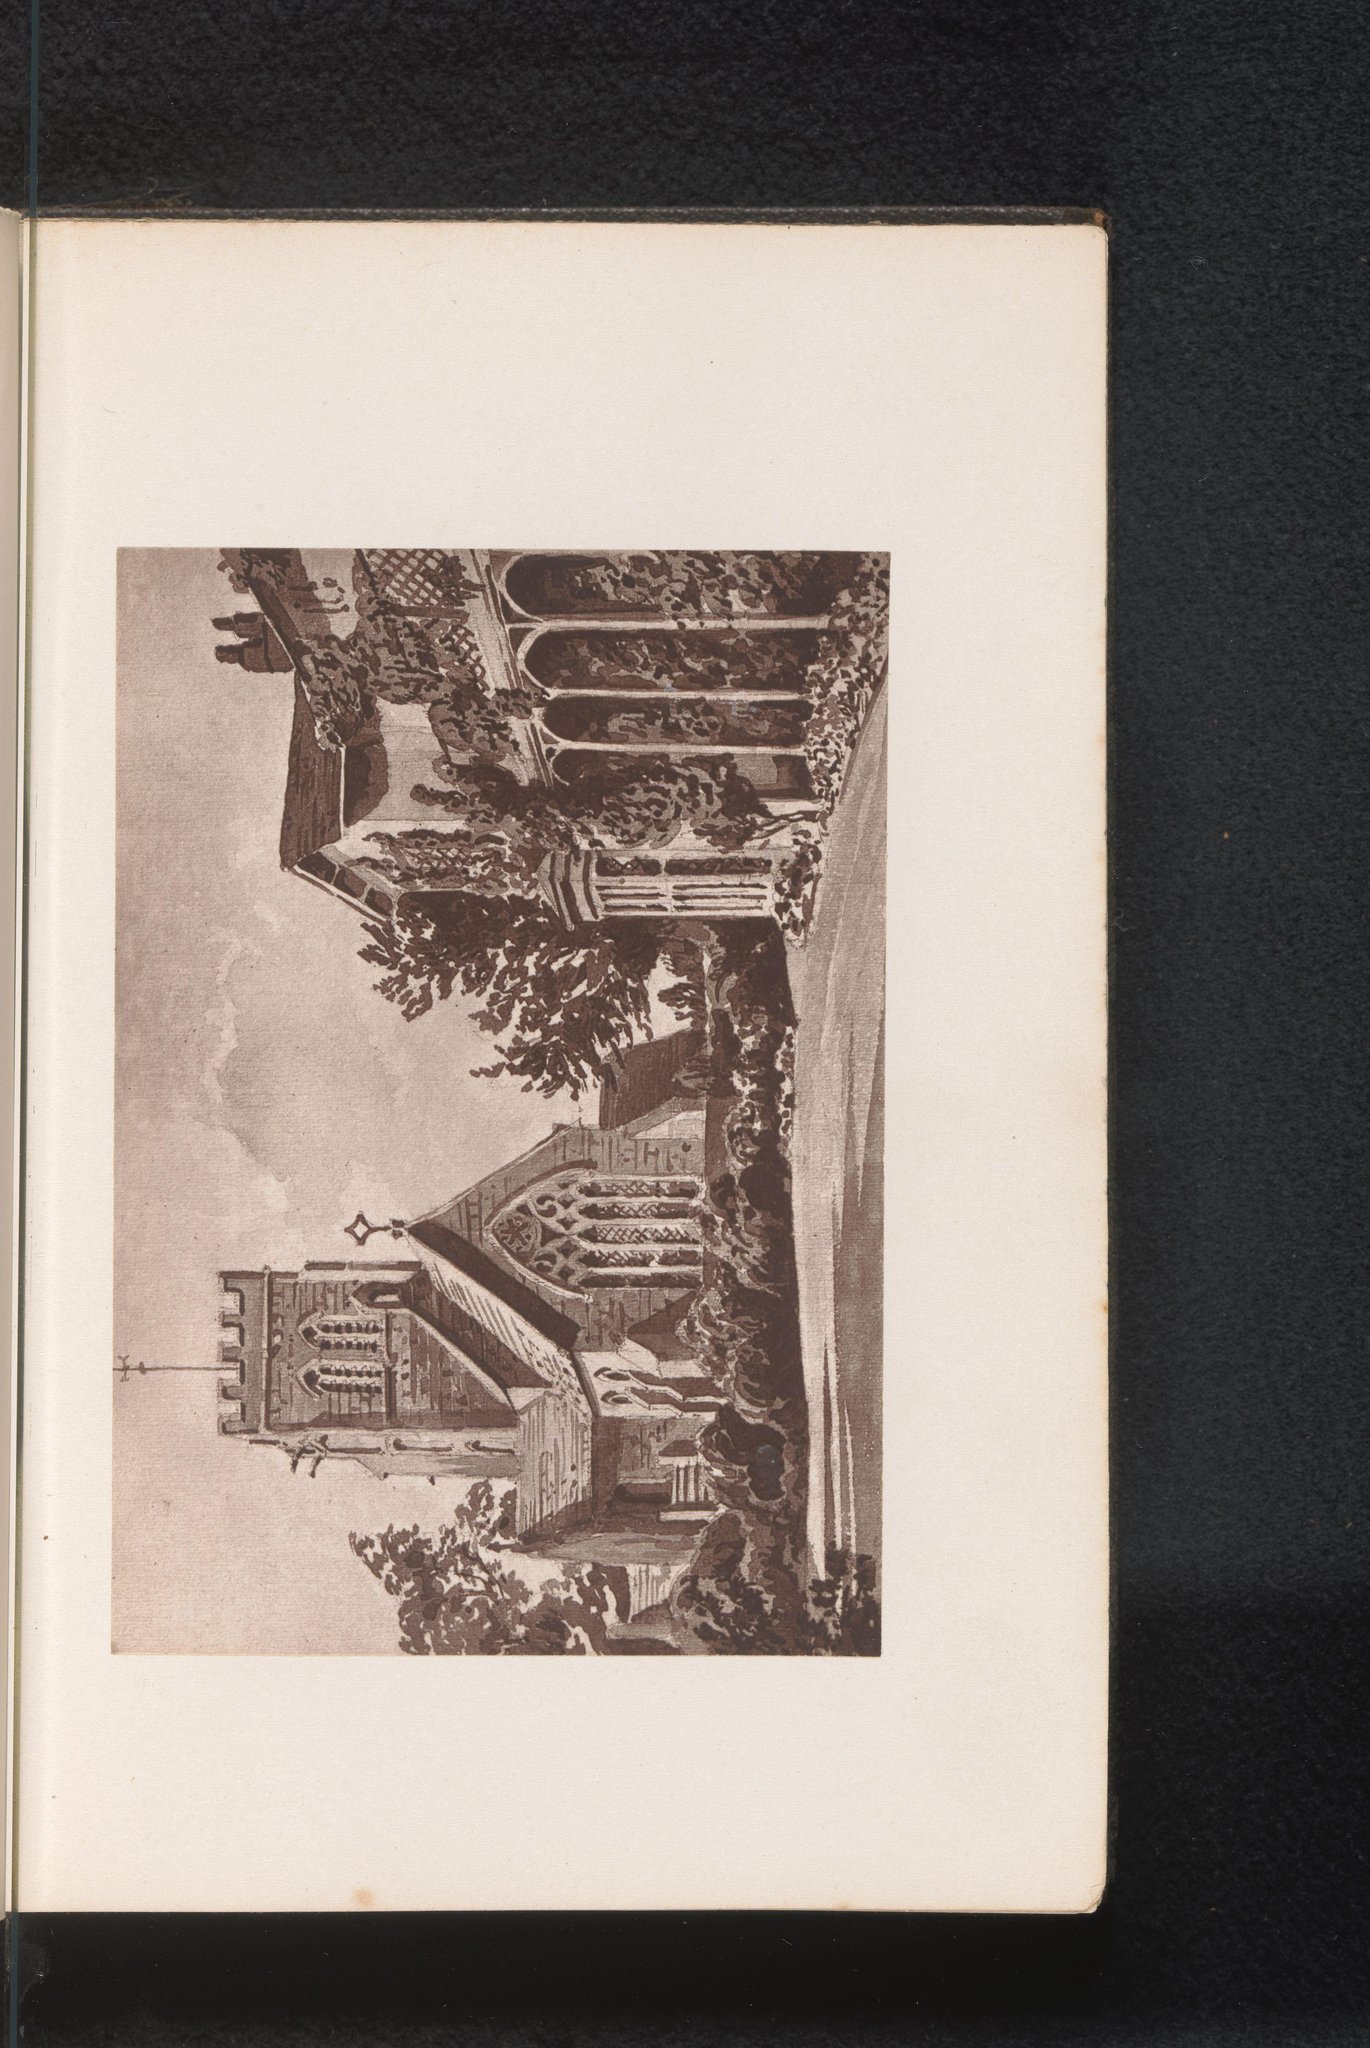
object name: page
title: Fotoreproductie van een schildering, voorstellende een gezicht op de pastorie en Saint Mary's Church te Nether Alderley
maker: Anonymous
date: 1866-1876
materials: paper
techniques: woodburytype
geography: nether alderley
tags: church (exterior), façade (of house or building)